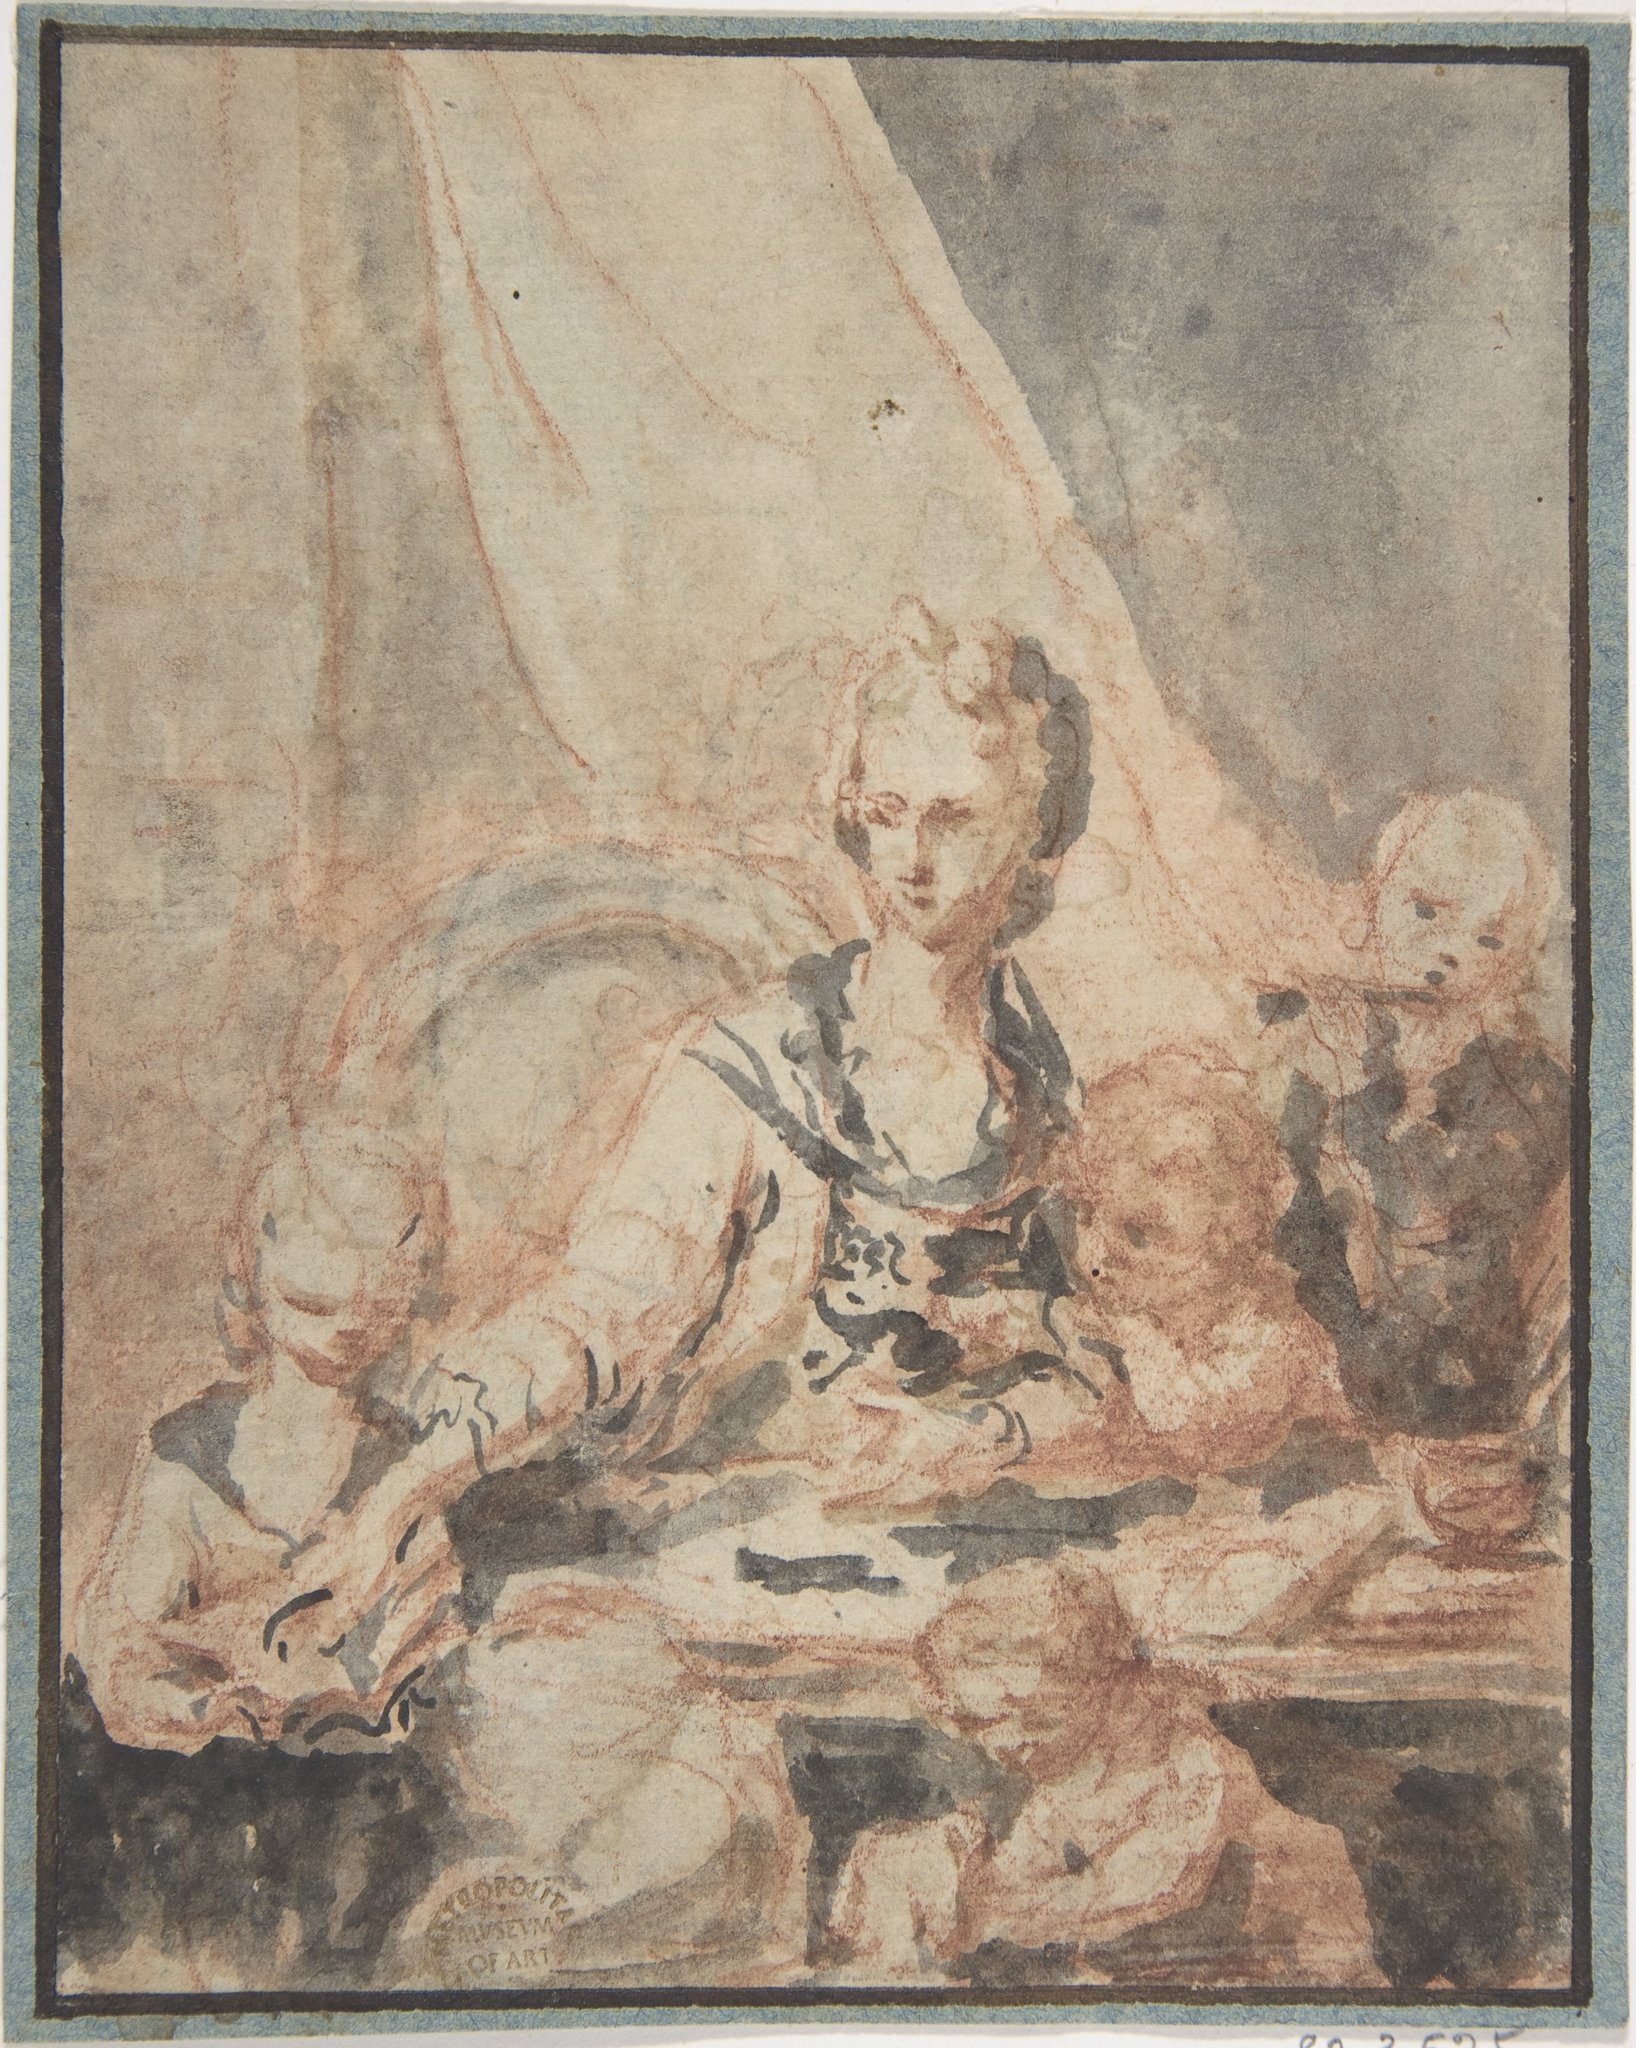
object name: drawing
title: Study for Portraits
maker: anonymous, french, 18th century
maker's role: artist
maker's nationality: french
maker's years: 1700-1800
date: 1701-1800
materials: chalk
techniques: brush, wash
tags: girls,infants,women,reading